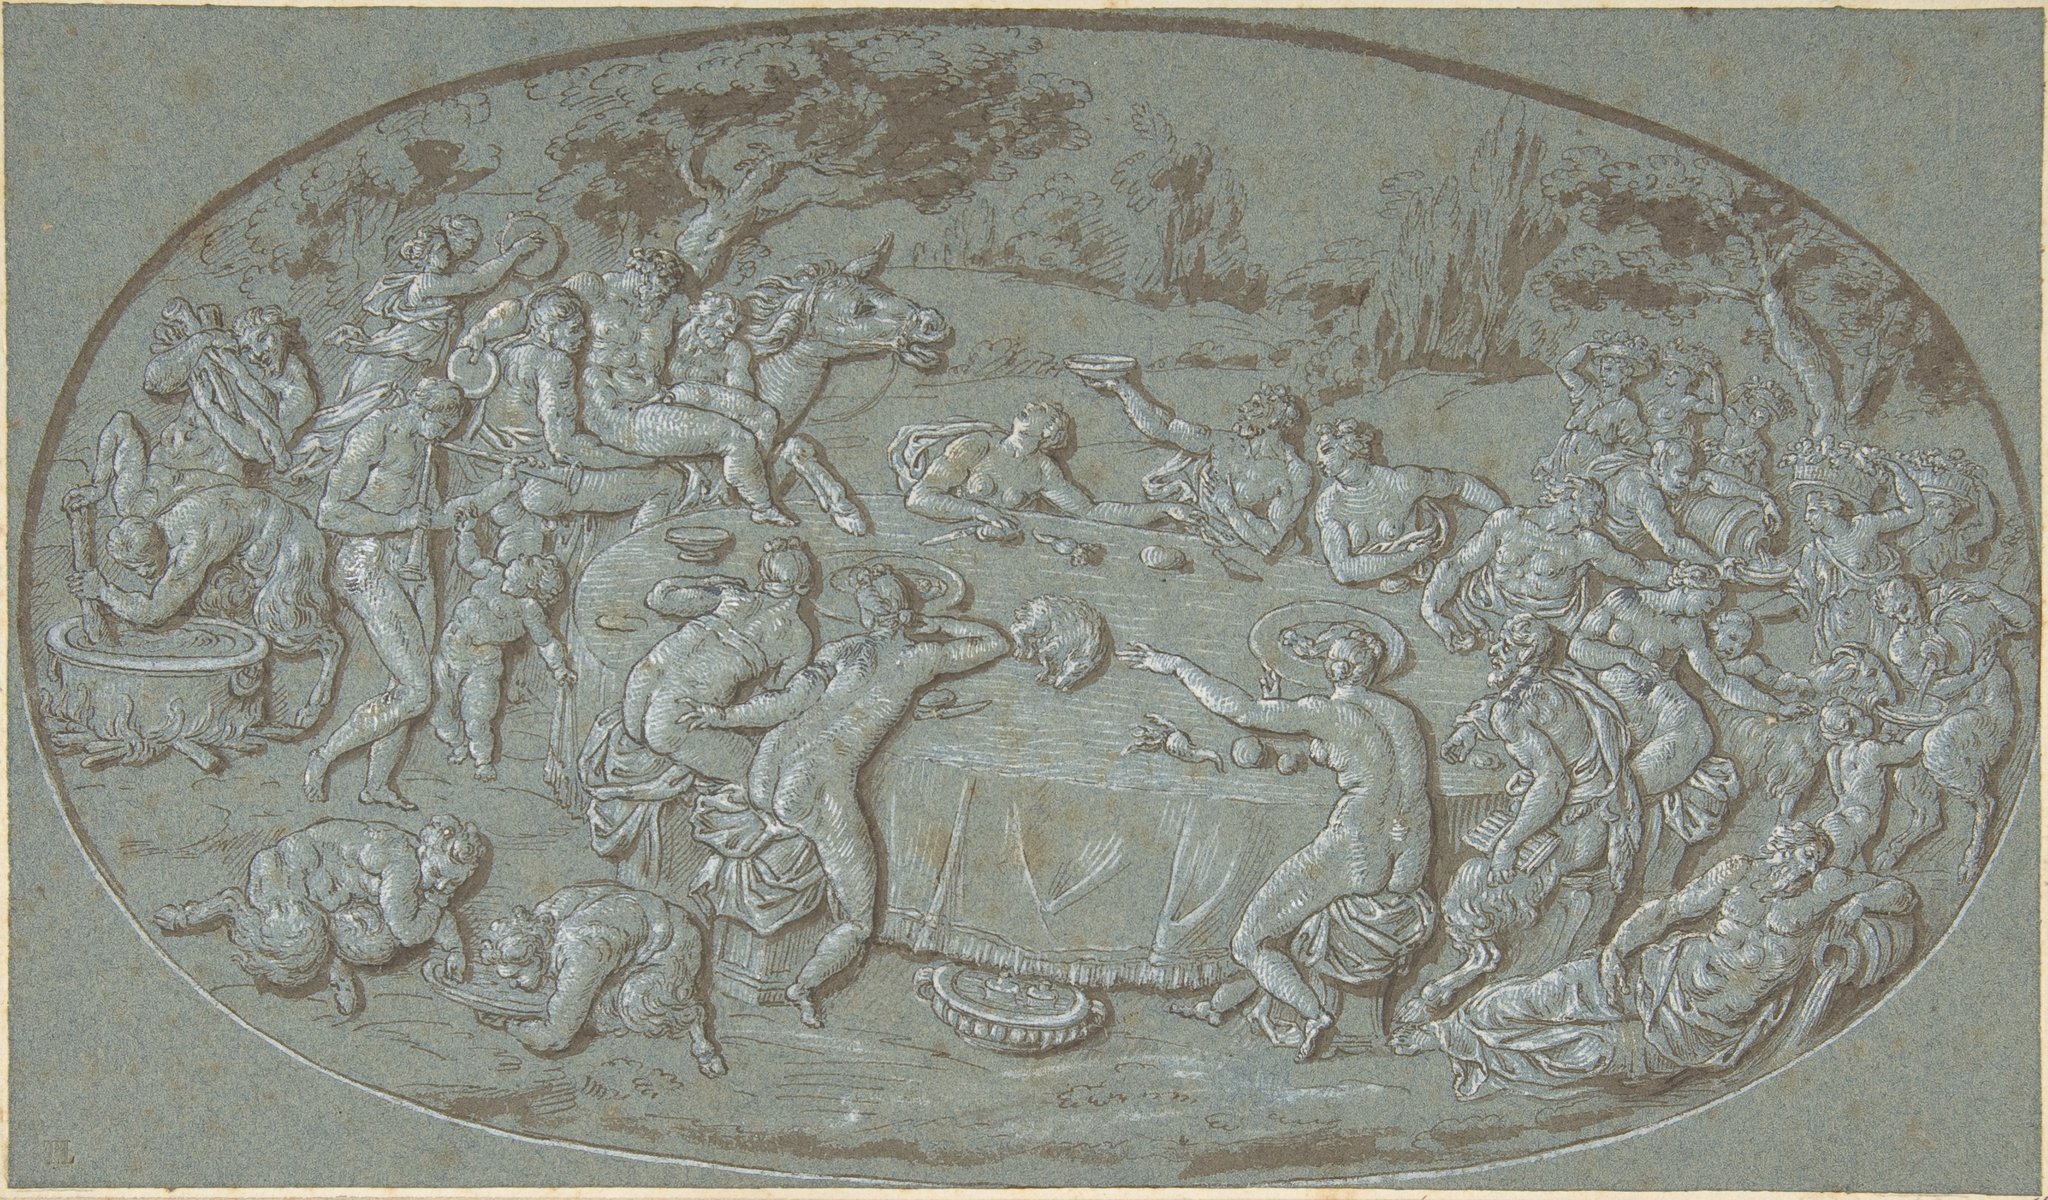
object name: drawing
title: King Midas Feasting At The Arrival of Silenus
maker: bernard picart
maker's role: artist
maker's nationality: french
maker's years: 1673-1733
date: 1667-1733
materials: ink, paper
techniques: heightening, pen, wash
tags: men,silenus,midas,horses